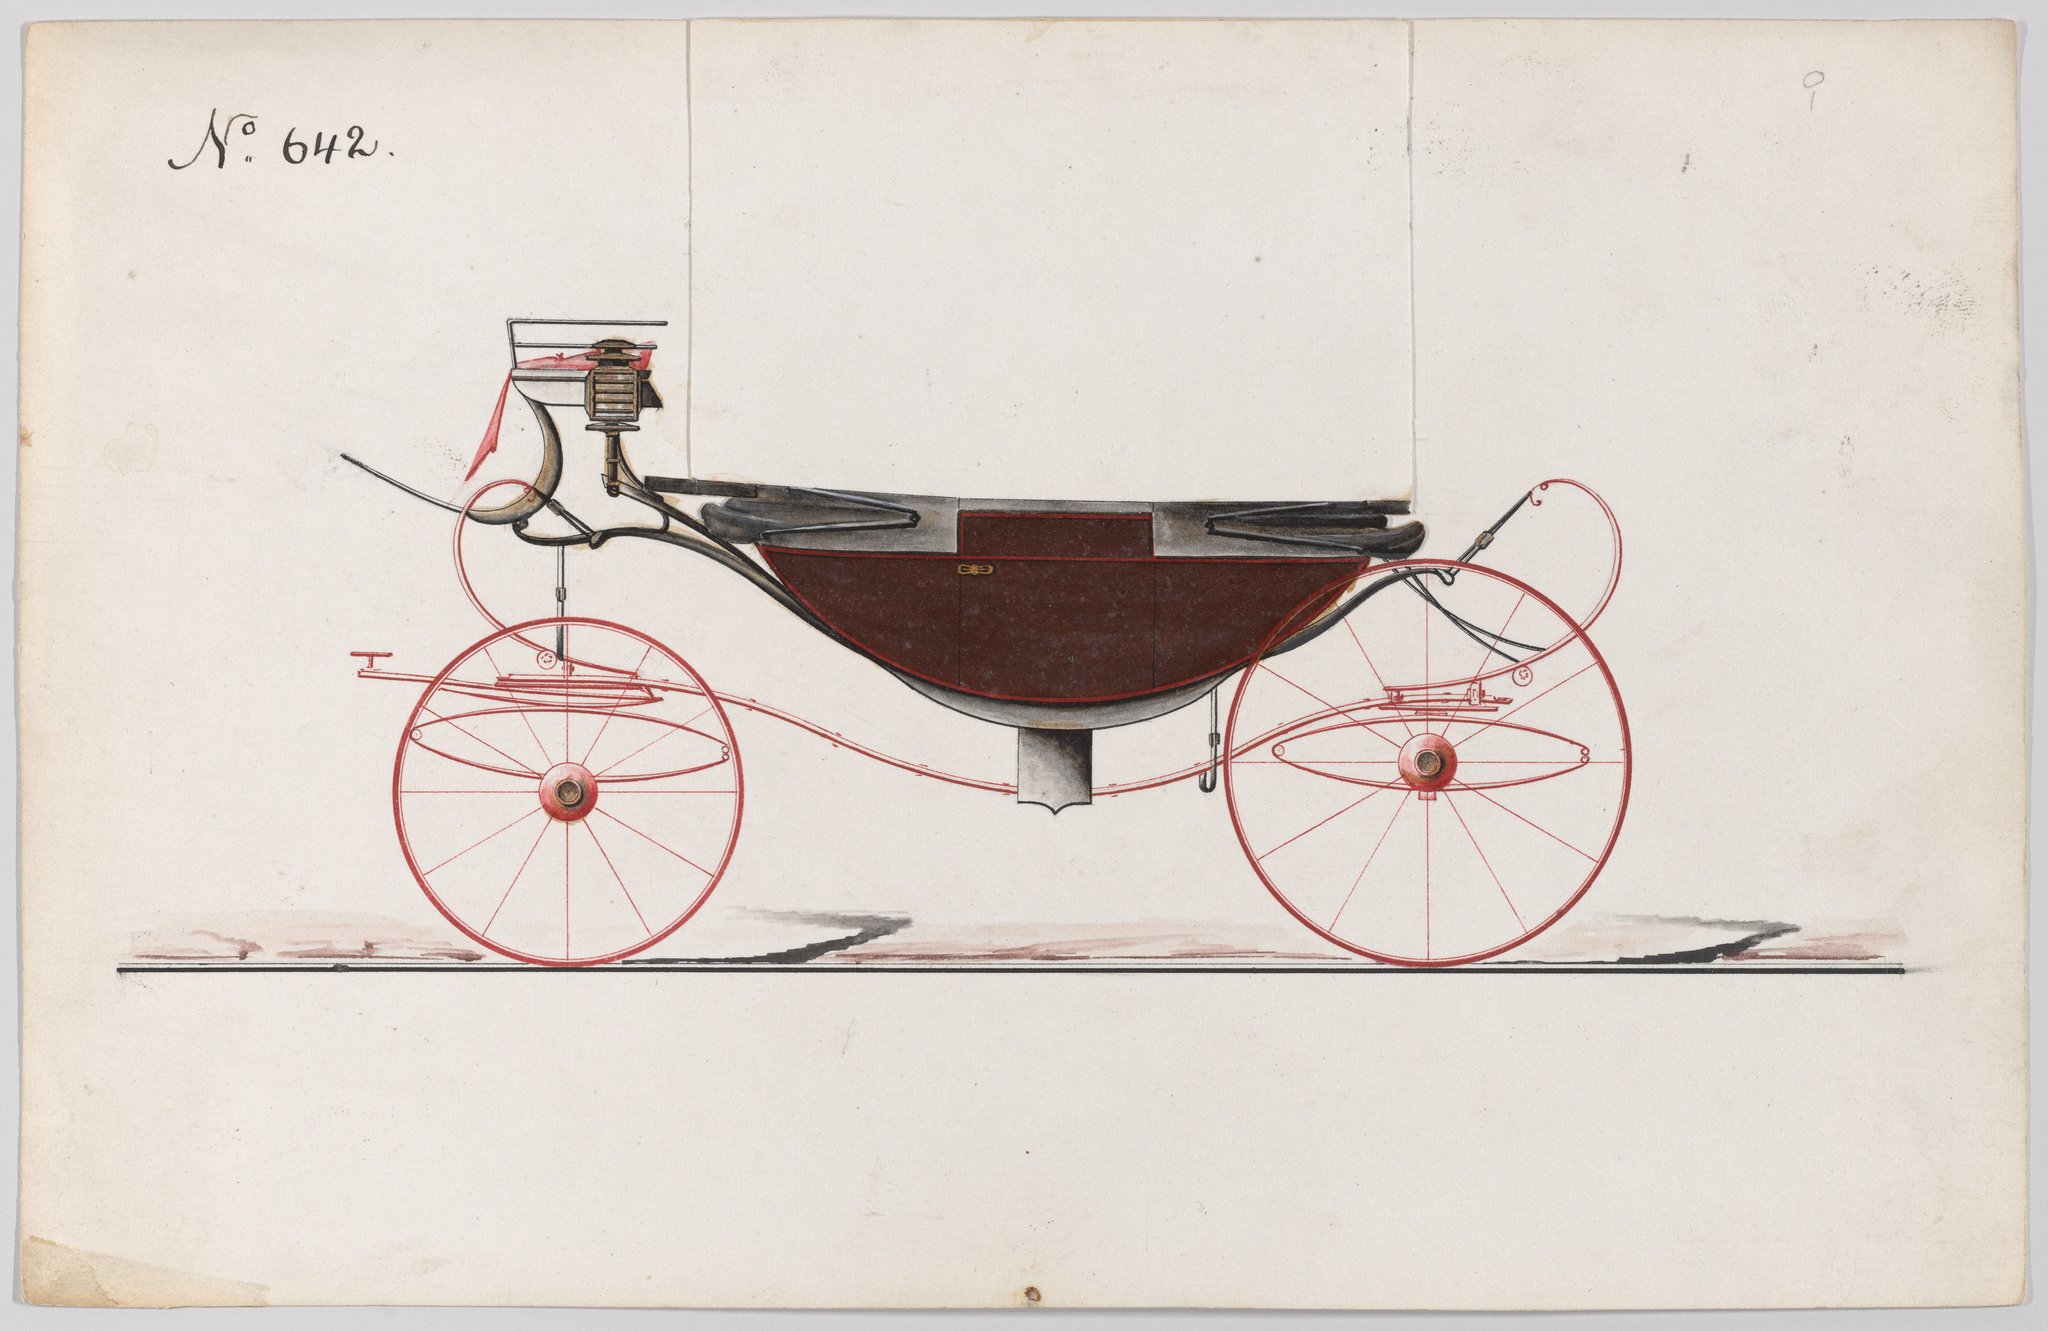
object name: drawing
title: Landau #642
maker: brewster & co.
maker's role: manufacturer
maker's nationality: american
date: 1850-1870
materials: gouache, gum arabic, ink, watercolor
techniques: pen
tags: carriages